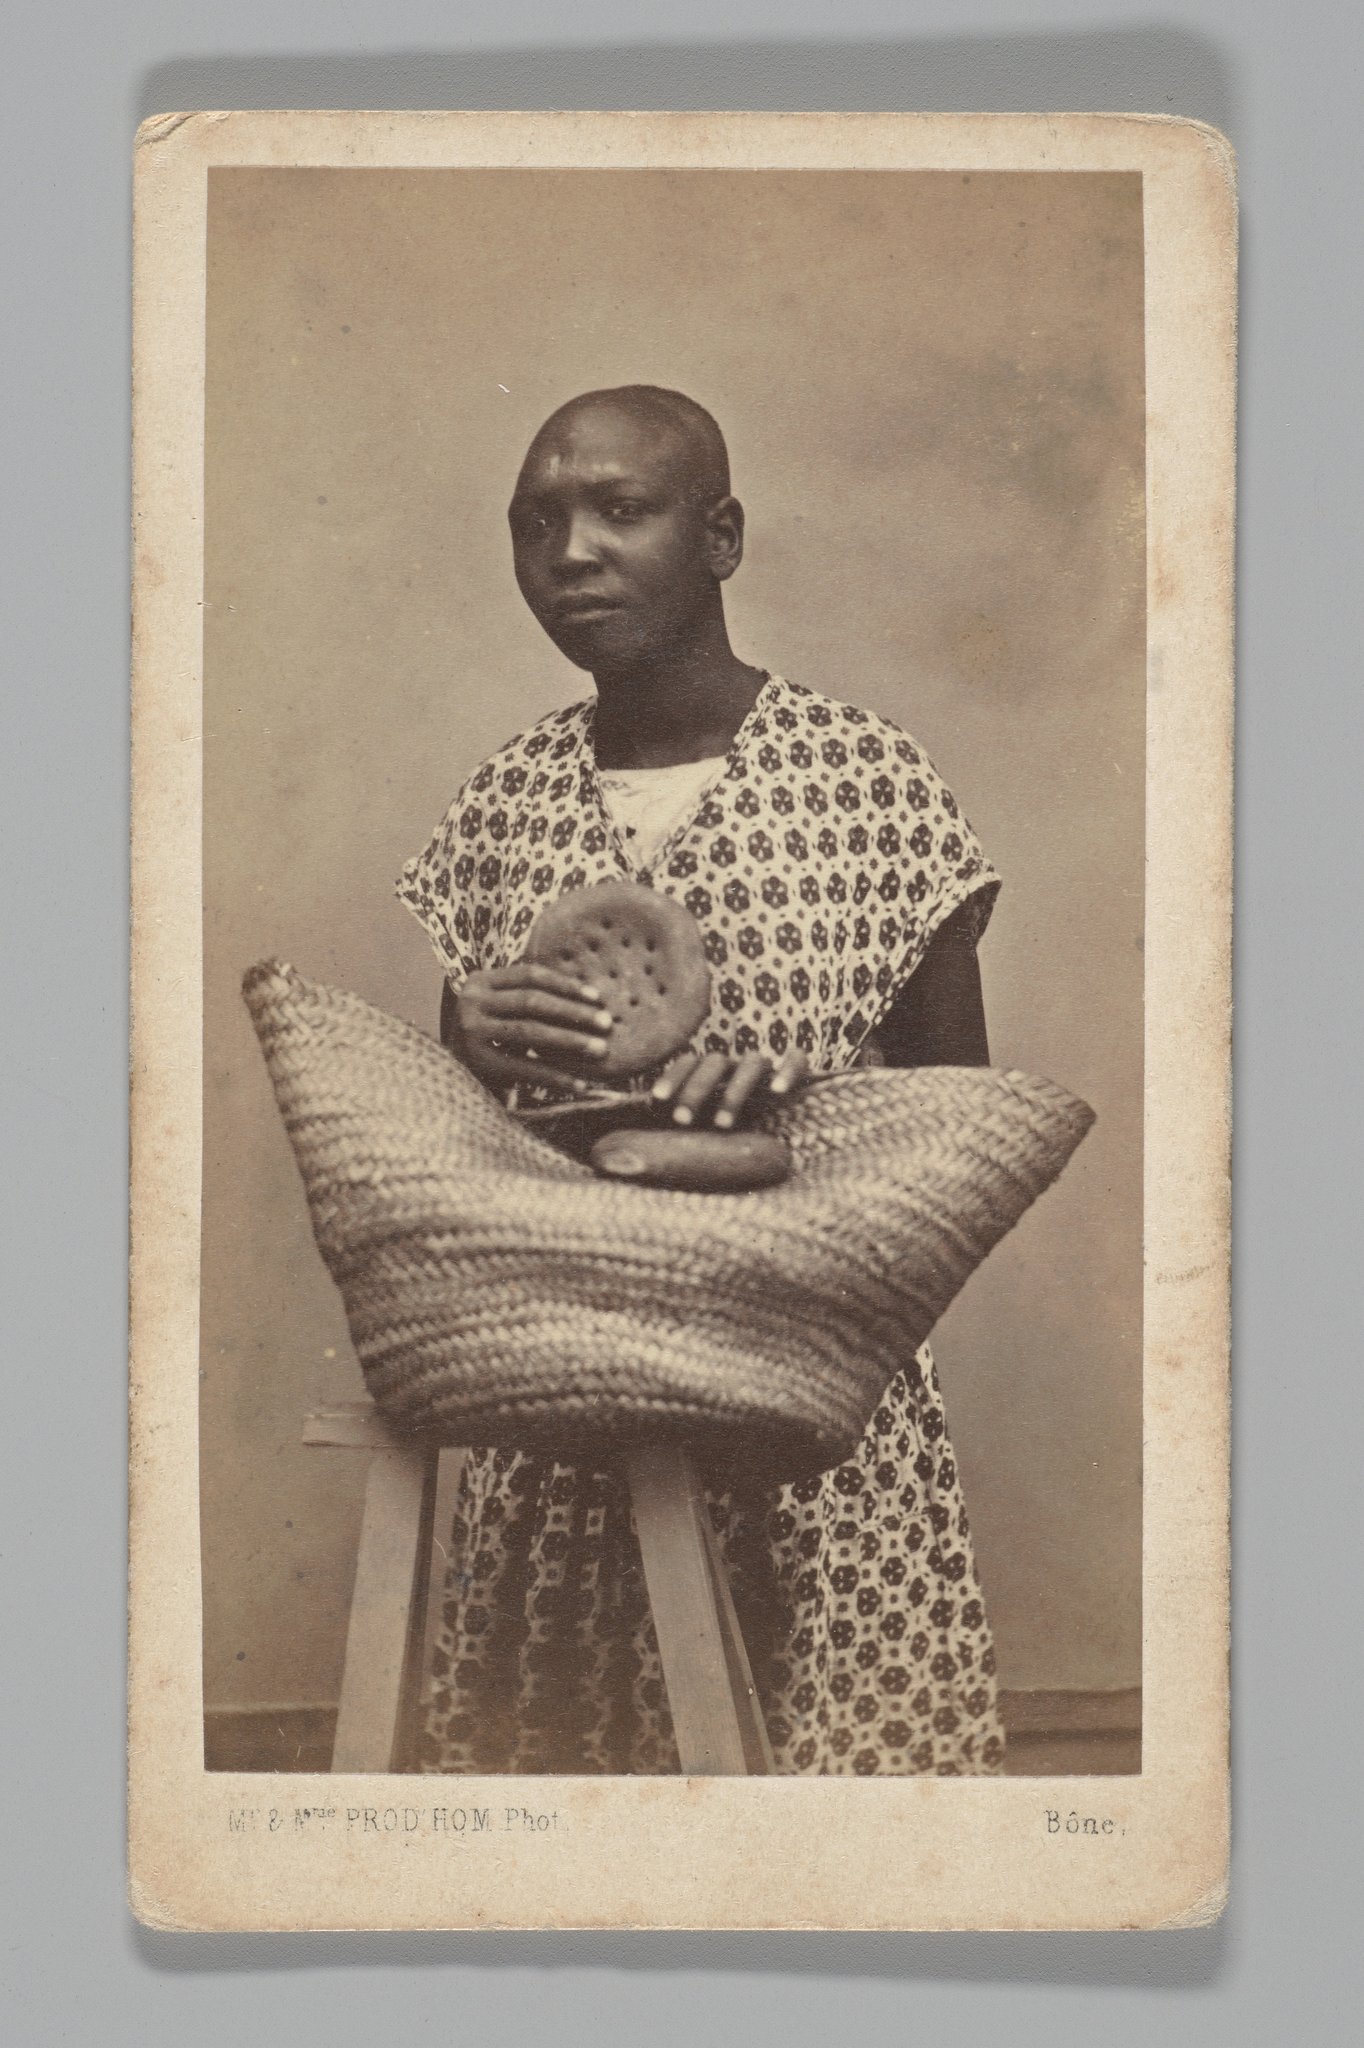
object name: carte de visite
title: [Studio Portrait: Woman with Straw Basket, Algeria]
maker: maison prod'hom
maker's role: photography studio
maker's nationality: swiss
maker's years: 1862-1900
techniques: albumen silver print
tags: portraits,women